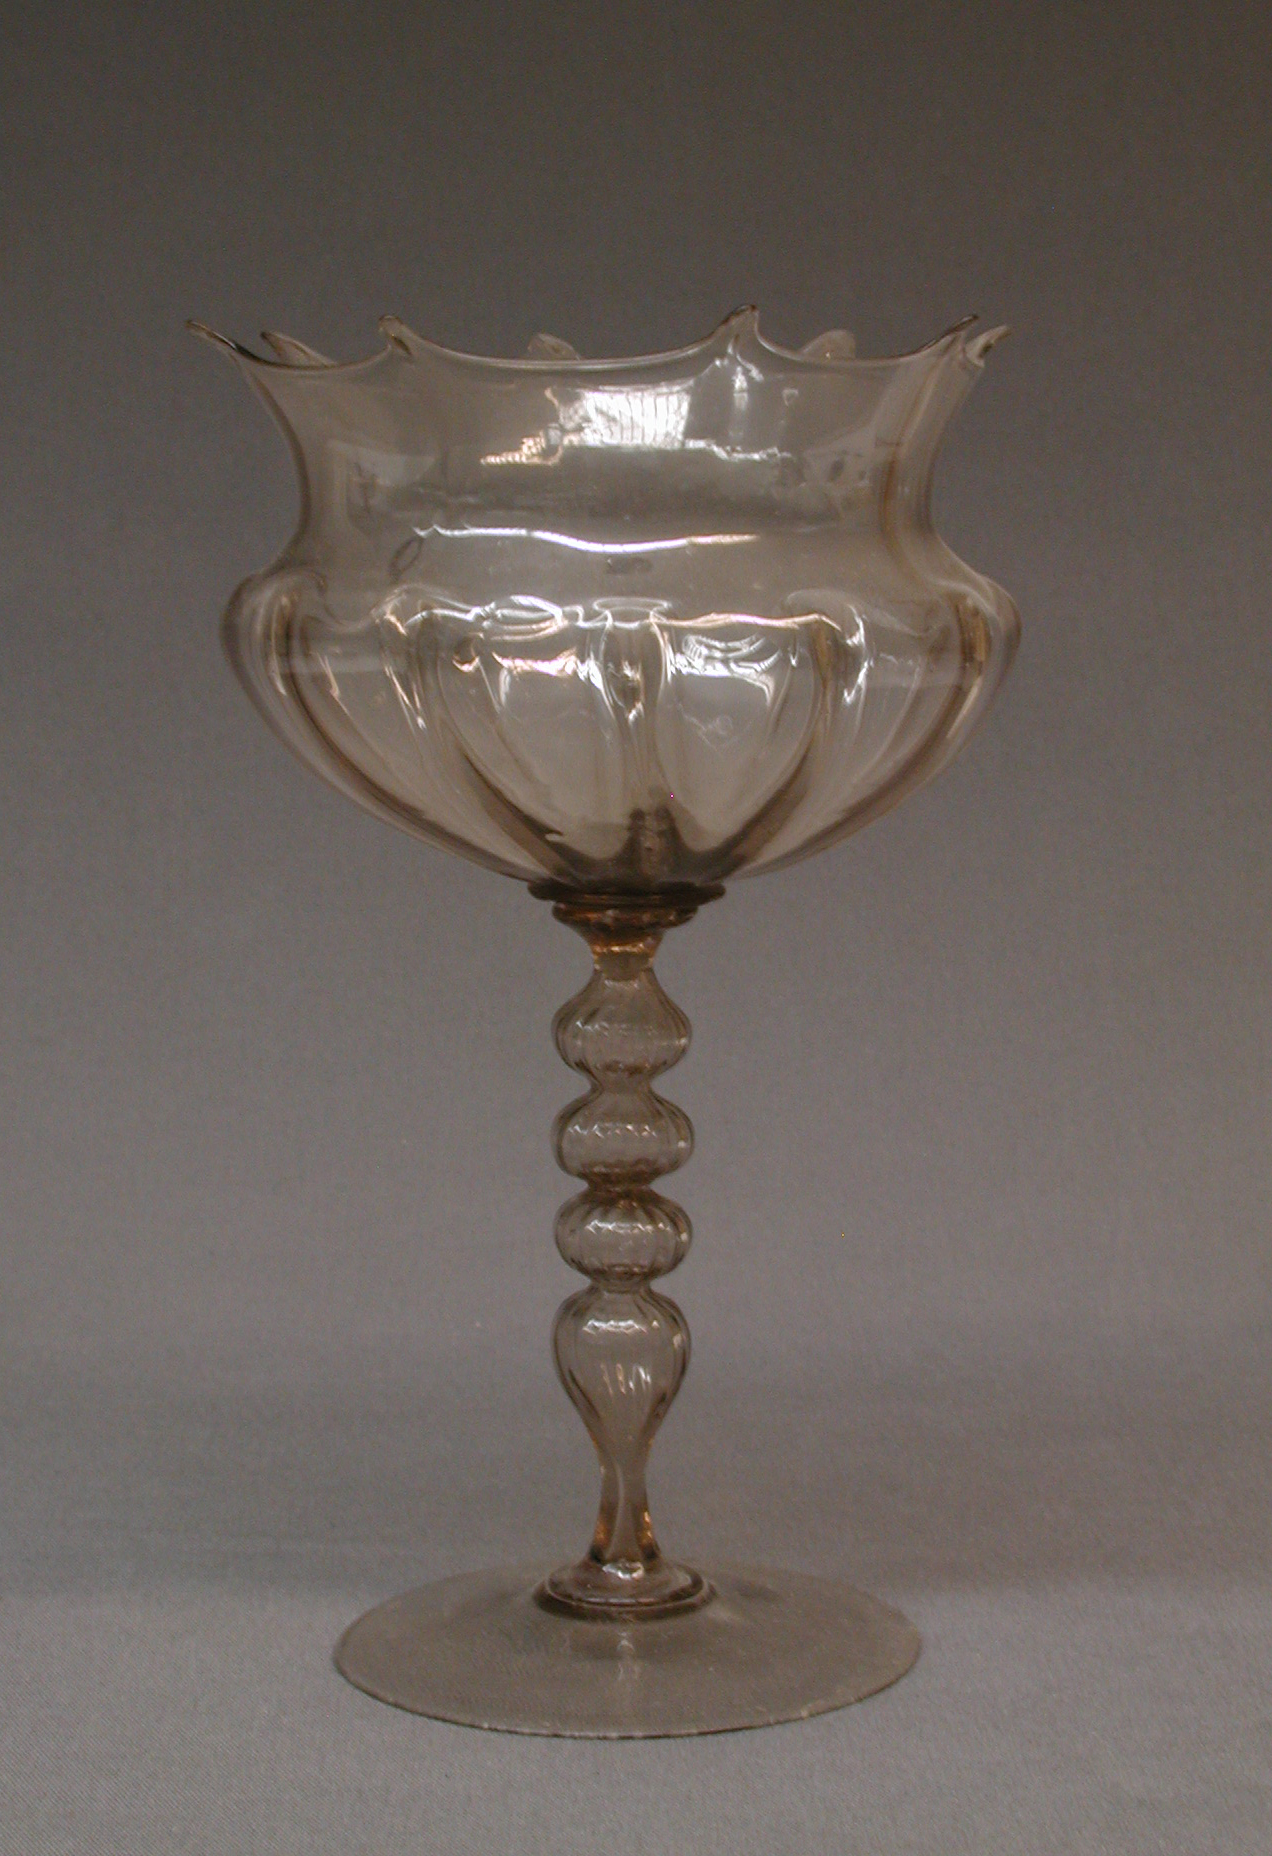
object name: goblet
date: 1801-1900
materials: glass